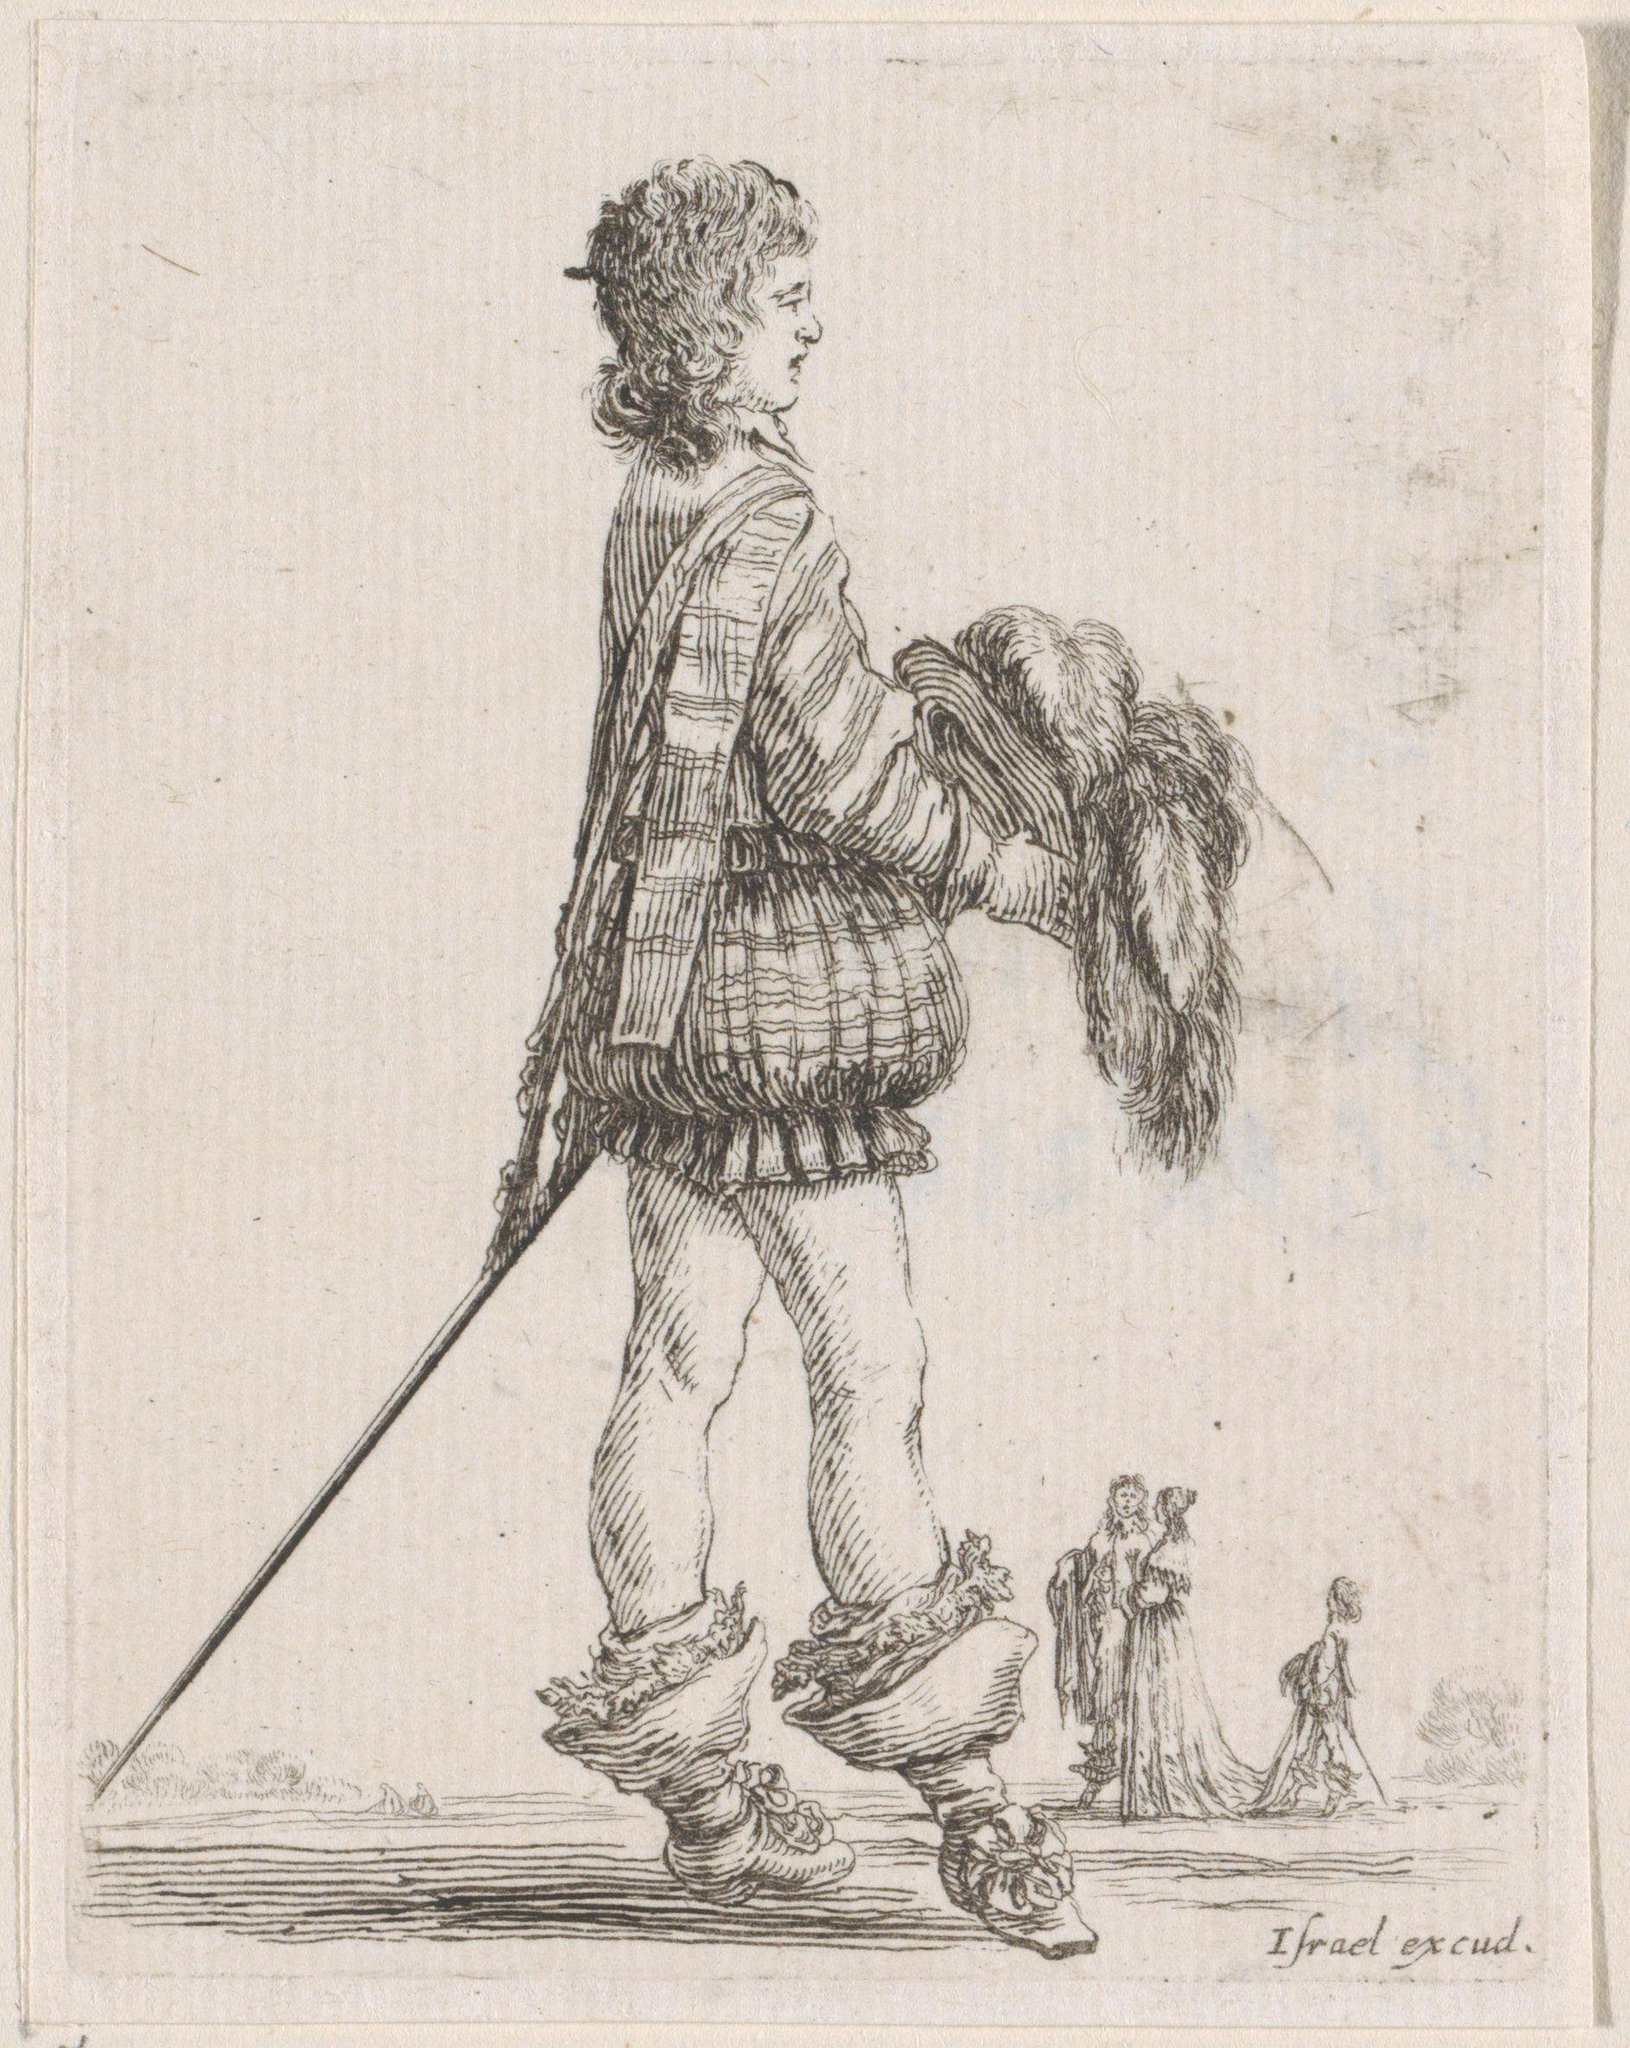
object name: print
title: Edelman met bepluimde hoed in de hand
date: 1620-1664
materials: paper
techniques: etching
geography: paris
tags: adult man, nobility and patriciate; chivalry, knighthood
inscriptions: collector's mark: Lugt 240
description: Op de voorgrond een rijk uitgedoste man, lopend naar rechts. In zijn hand houdt hij een hoed met veren. Op de achtergrond een wandelend paar met dochter.